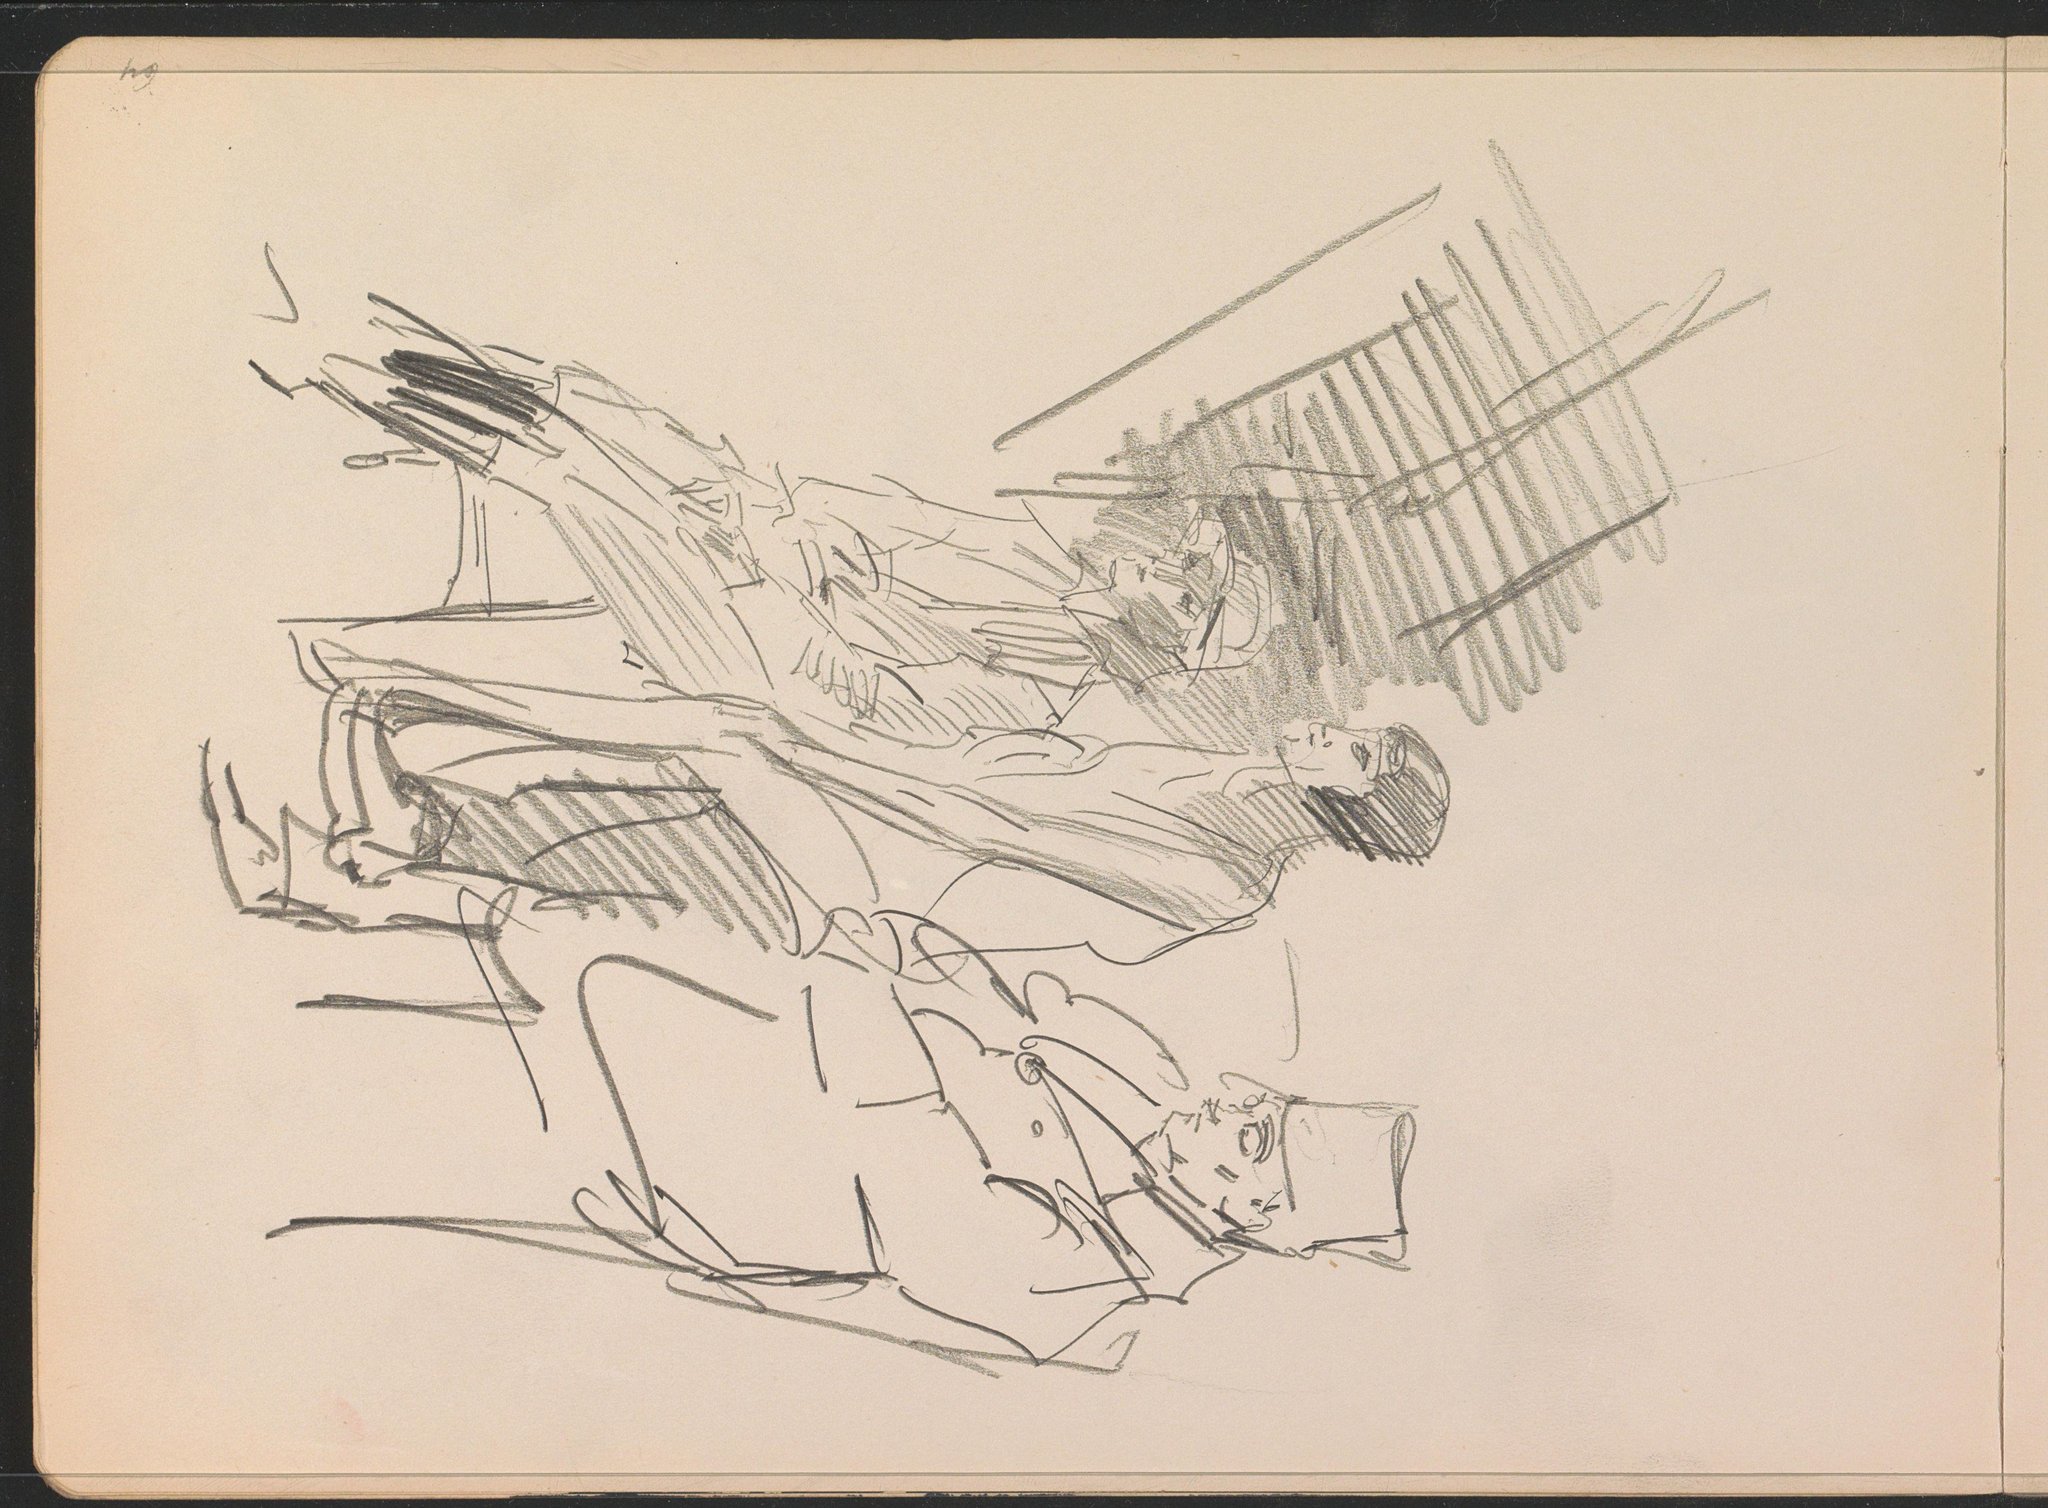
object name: sketchbook leaf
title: Drie zittende figuren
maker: isaac israels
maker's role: draughtsman, painter, print maker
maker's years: 1865-1934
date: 1915-1934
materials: paper, pencil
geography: the hague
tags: sitting on an elevation, sitting on an elevation - aa - female human figure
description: Op stoelen. Mogelijk twee vrouwen en een man. Blad 3 verso uit schetsboek VI met 33 bladen.